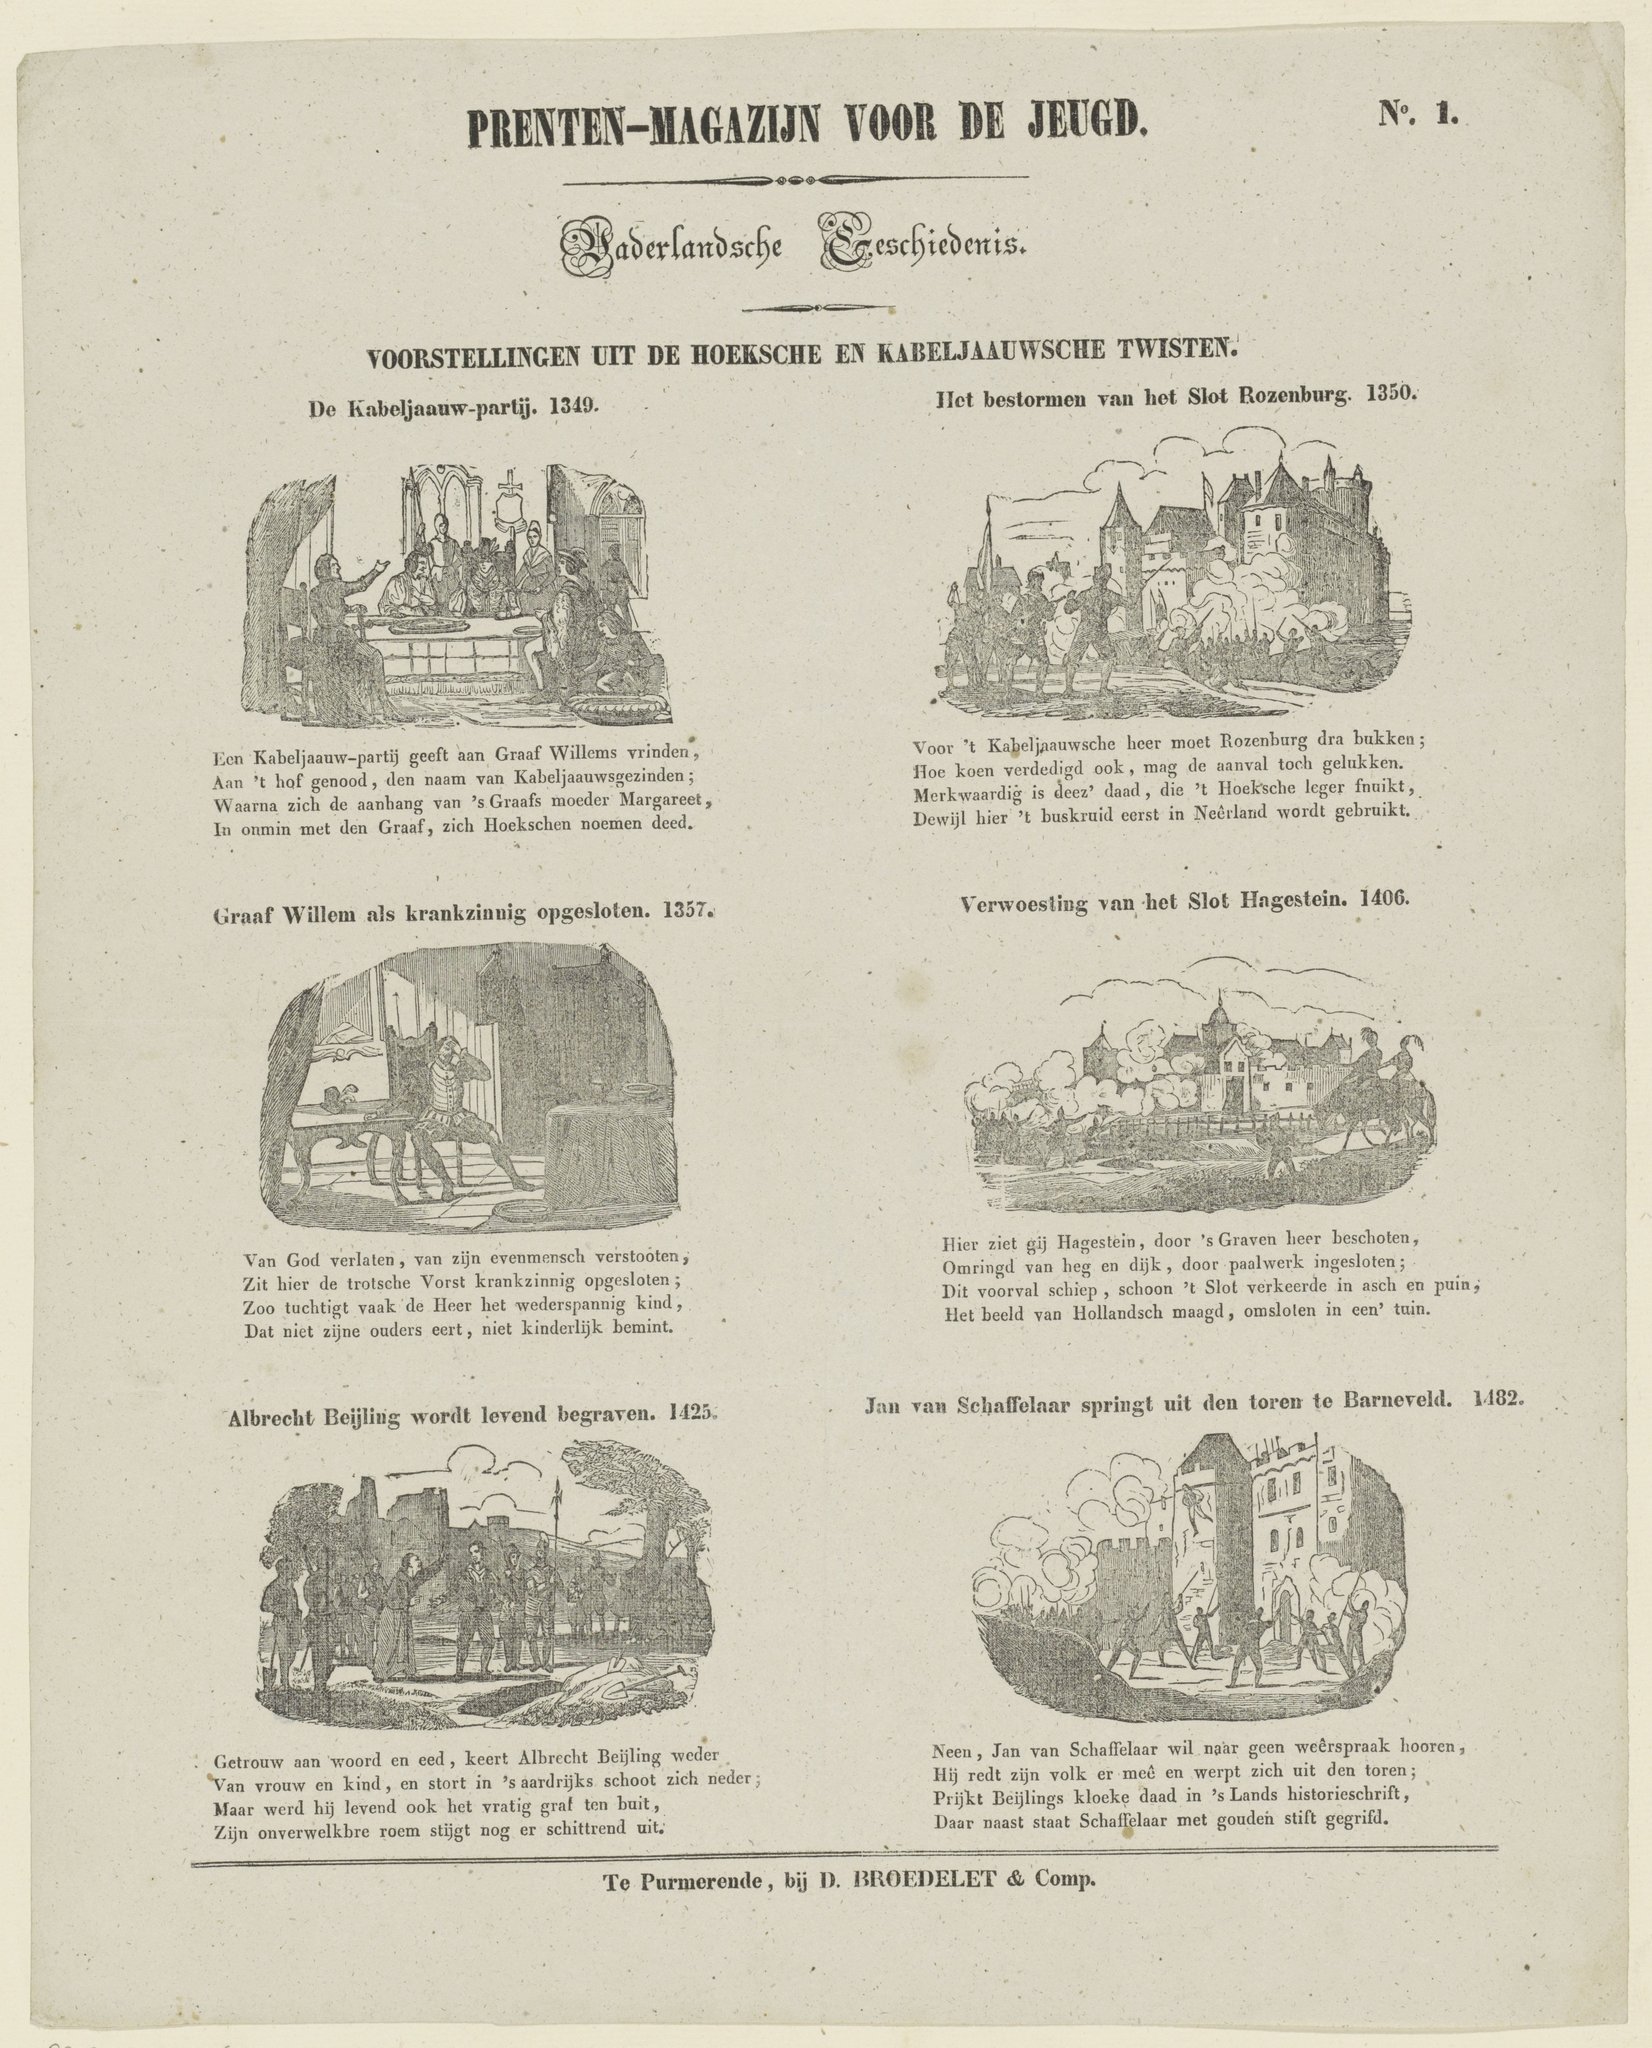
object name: popular print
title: Voorstellingen uit de Hoeksche en Kabeljaauwsche twisten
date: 1841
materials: paper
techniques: letterpress printing, engraving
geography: purmerend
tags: earl, willem v van holland (graaf van holland en zeeland), history, palace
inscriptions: collector's mark: Lugt 2760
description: Blad met 6 voorstellingen van de Hoekse en Kabeljauwse twisten, zoals Graaf Willem die wordt opgesloten, de verwoesting van Slot Hagestein en Jan Schaffelaar die uit de toren te Barneveld springt. Boven elke voorstelling een titel en jaartal en onder elke voorstelling een vierregelig vers. Genummerd rechtsboven: No. 1.